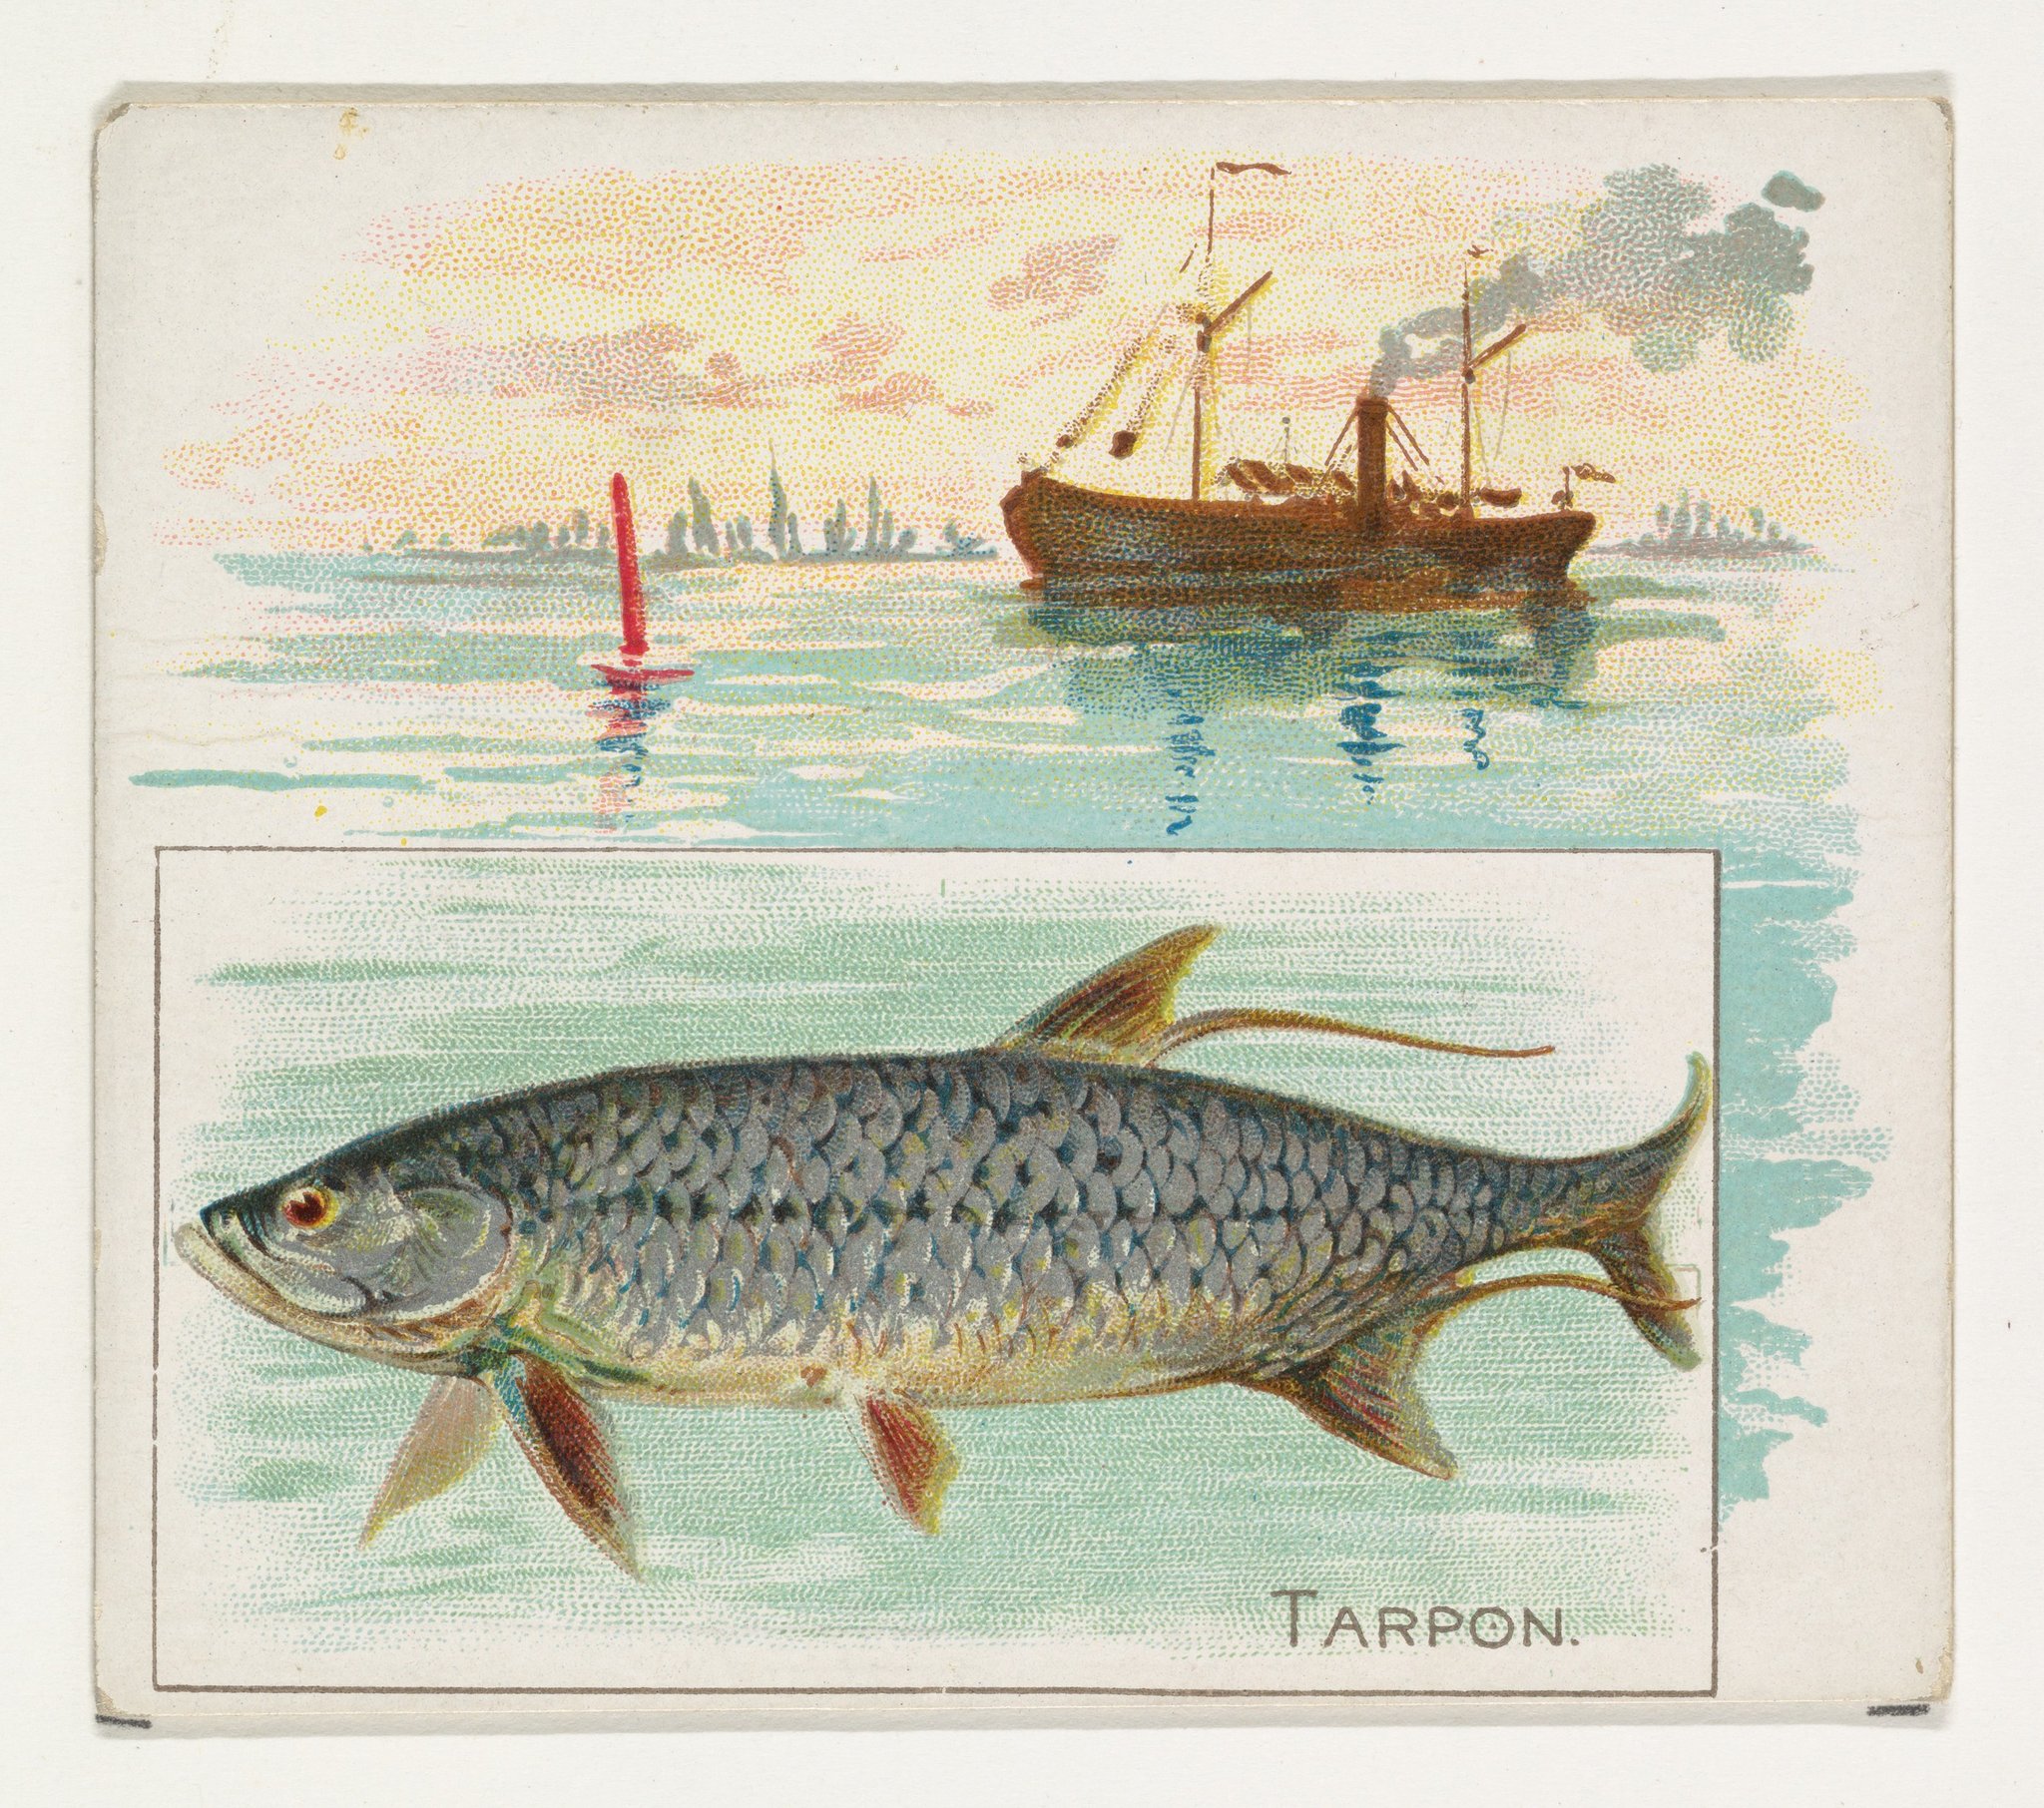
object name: print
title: Tarpon, from Fish from American Waters series (N39) for Allen & Ginter Cigarettes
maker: allen & ginter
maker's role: publisher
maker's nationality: american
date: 1889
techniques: color lithograph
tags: fish,ships